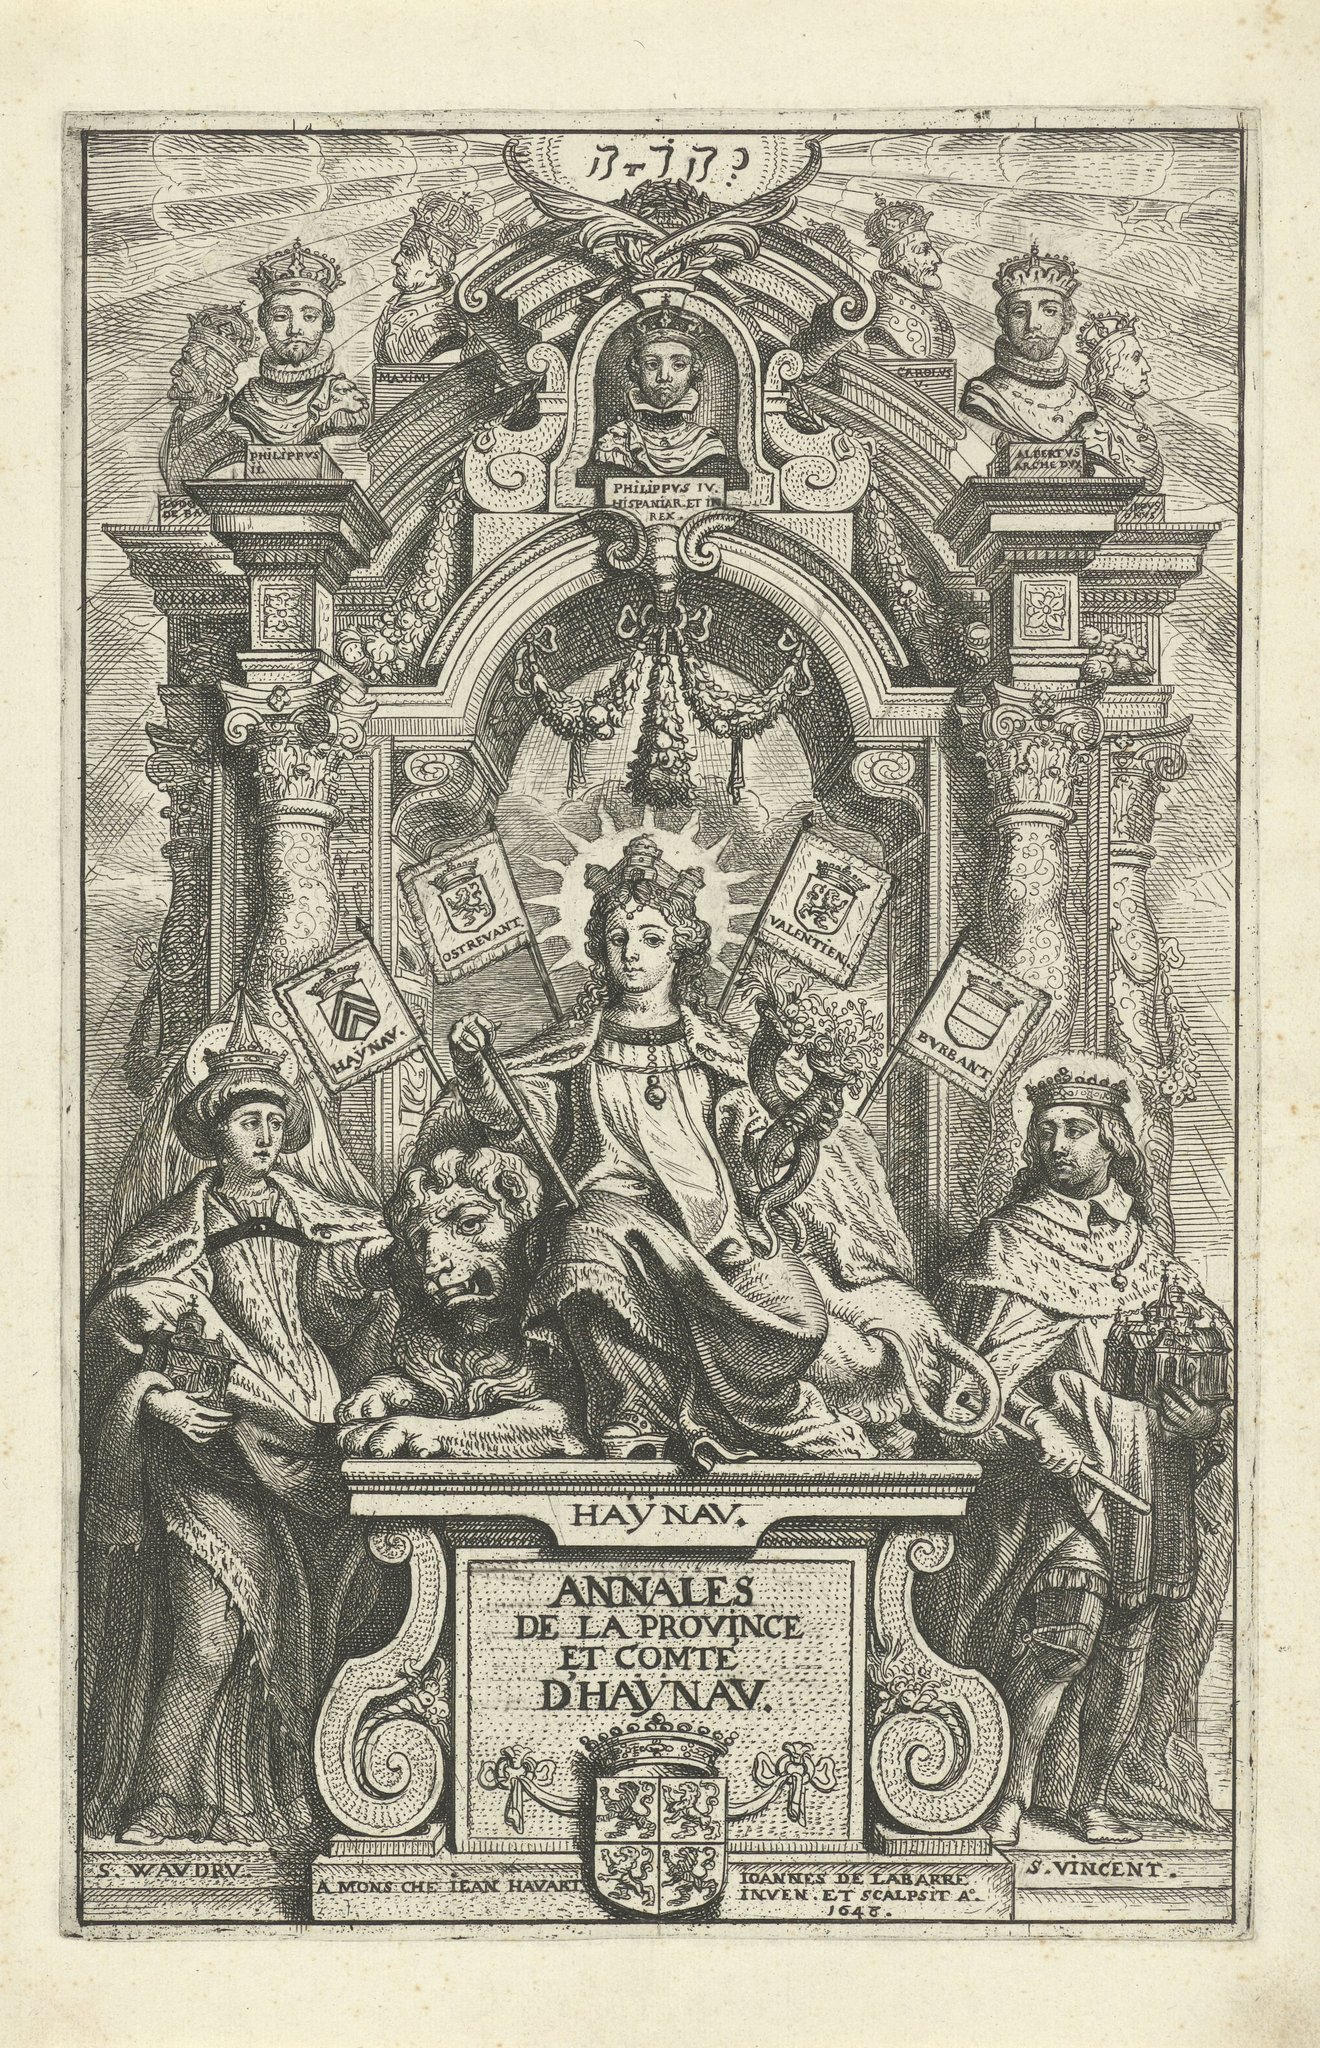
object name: titelblad, titelpagina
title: Titelpagina voor: D'annales de la province et comté d'Hainau, 1648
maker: jean de la barre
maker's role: print maker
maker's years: 1603-1668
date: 1648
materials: paper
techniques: etching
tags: filips iv (koning van spanje)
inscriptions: collector's mark: Lugt 2228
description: De personificatie van de provincie en het graafschap Henegouwen, in de gedaante van een vrouw, zittend op een leeuw met een scepter en een stedekroon op het hoofd. Achter haar de wapens van Henegouwen, Oosterbant, Valenciennes en Brabant. Links staat de beschermheilige van de stad Bergen, Waldetrudis, en rechts haar echtgenoot, de graaf van Henegouwen, Vincentius Madelgarius. Op de achtergrond een architecturale omlijsting met borstbeelden van diverse heersers, centraal geplaatst het beeld van Filips IV van Spanje. Geheel bovenin het tetragram.